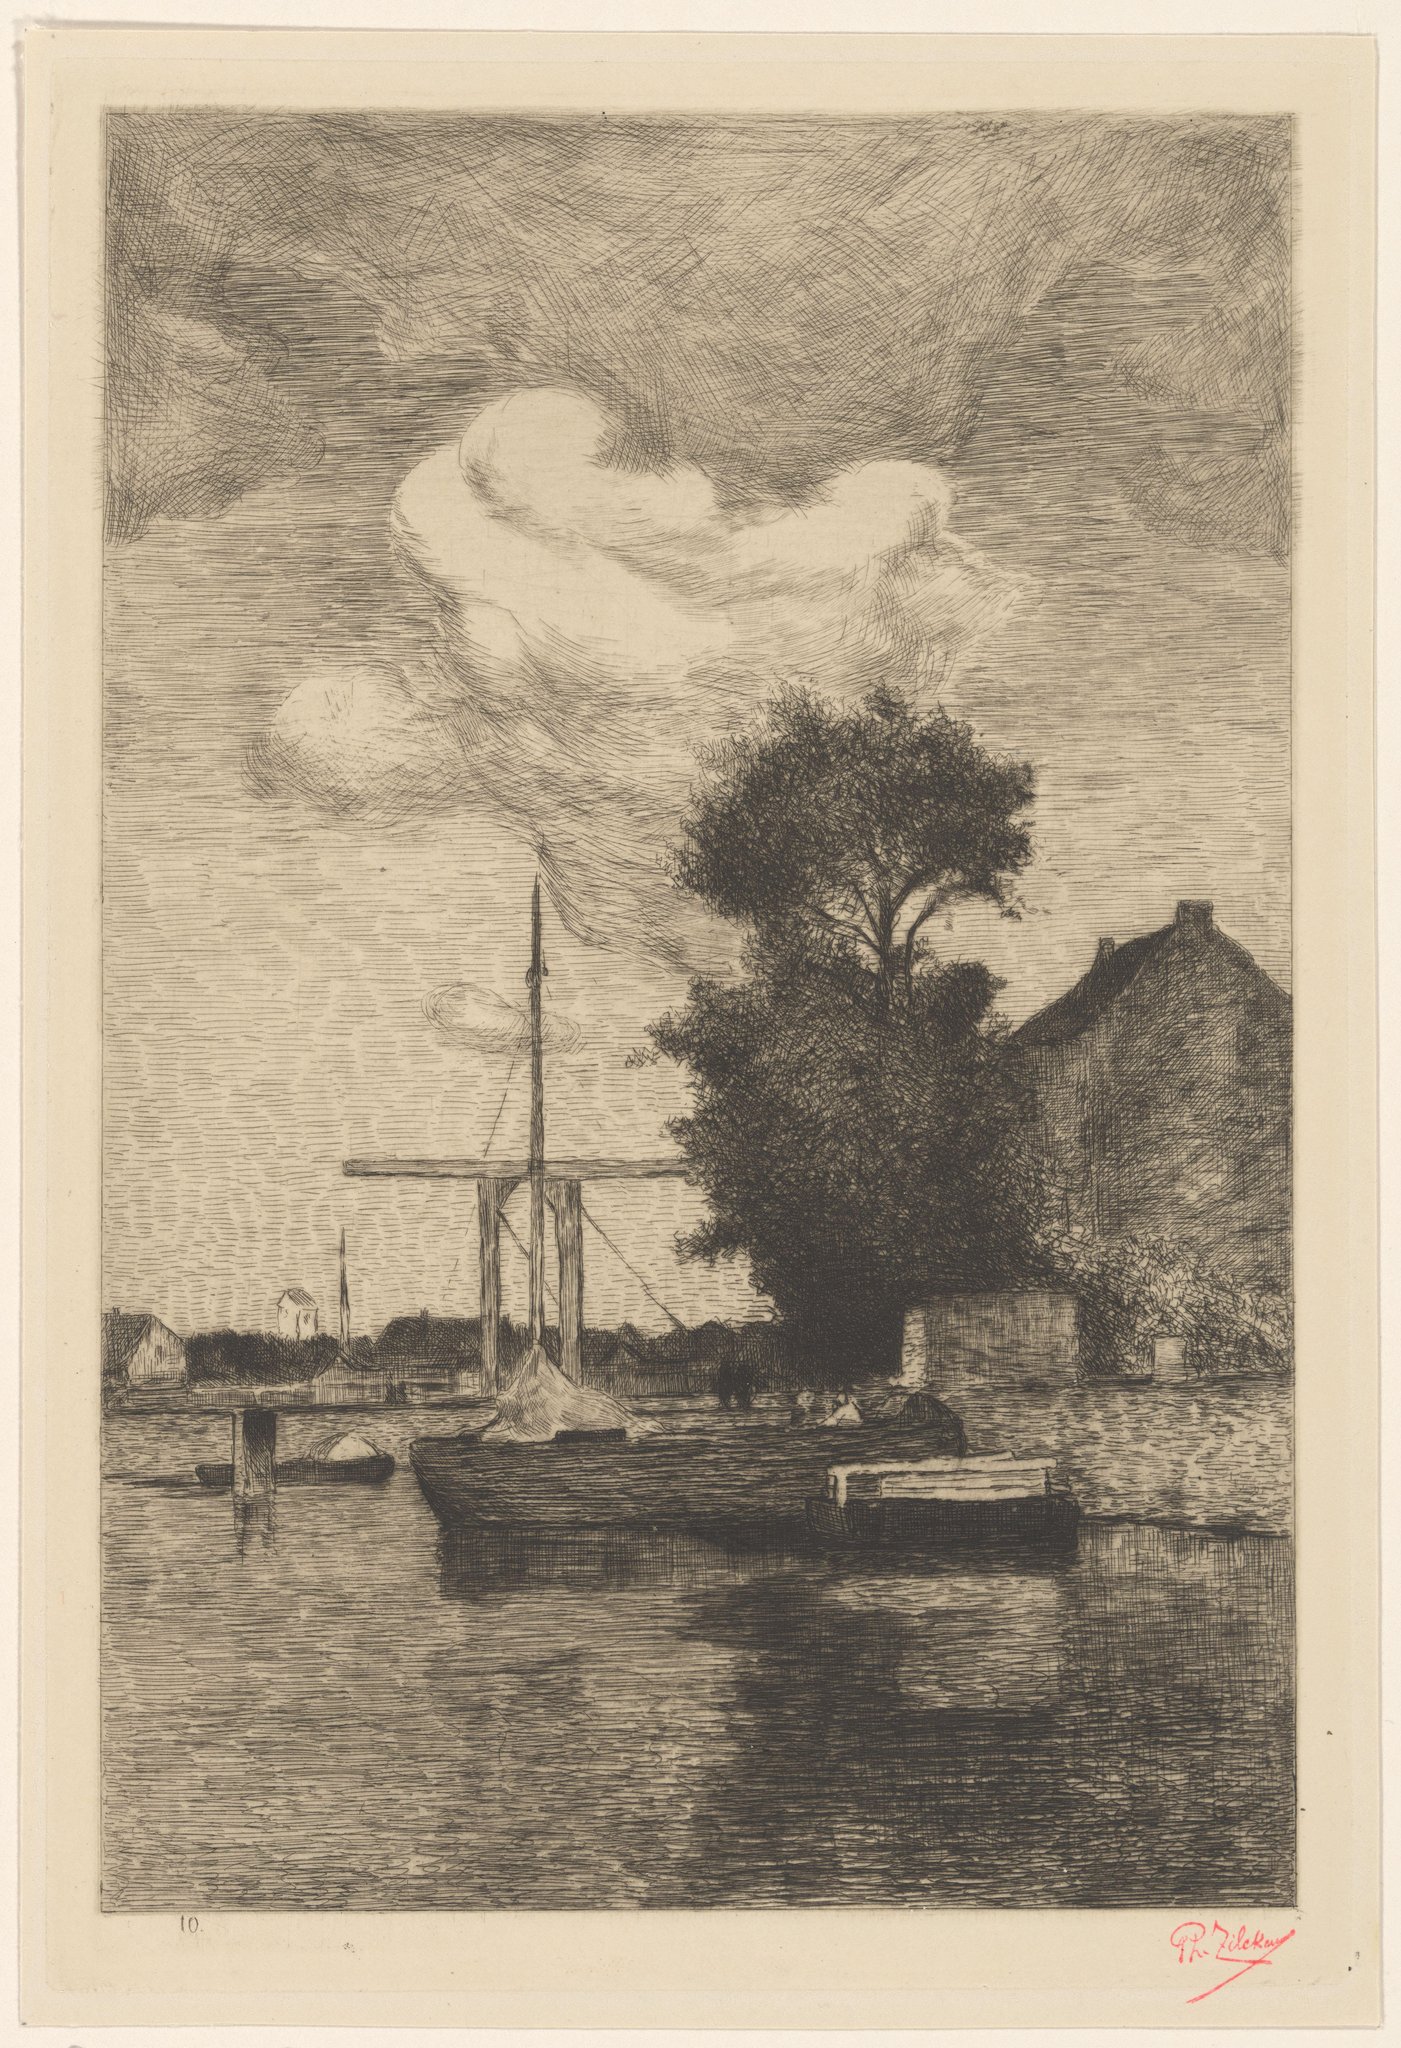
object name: print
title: Riviergezicht met brug en zeilboot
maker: philip zilcken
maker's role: draughtsman, painter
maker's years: 1857-1930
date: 1867-1890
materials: paper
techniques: etching, intaglio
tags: sailing-ship, sailing-boat, river, bridge, haarlem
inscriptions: number: ‘10’, collector's mark: Lugt 2228